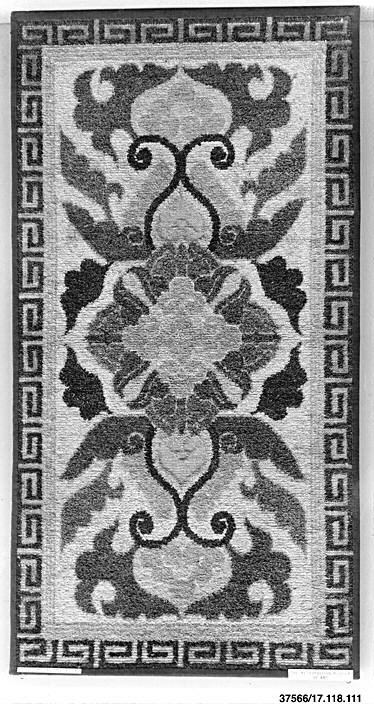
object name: carpet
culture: japanese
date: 1701-1733